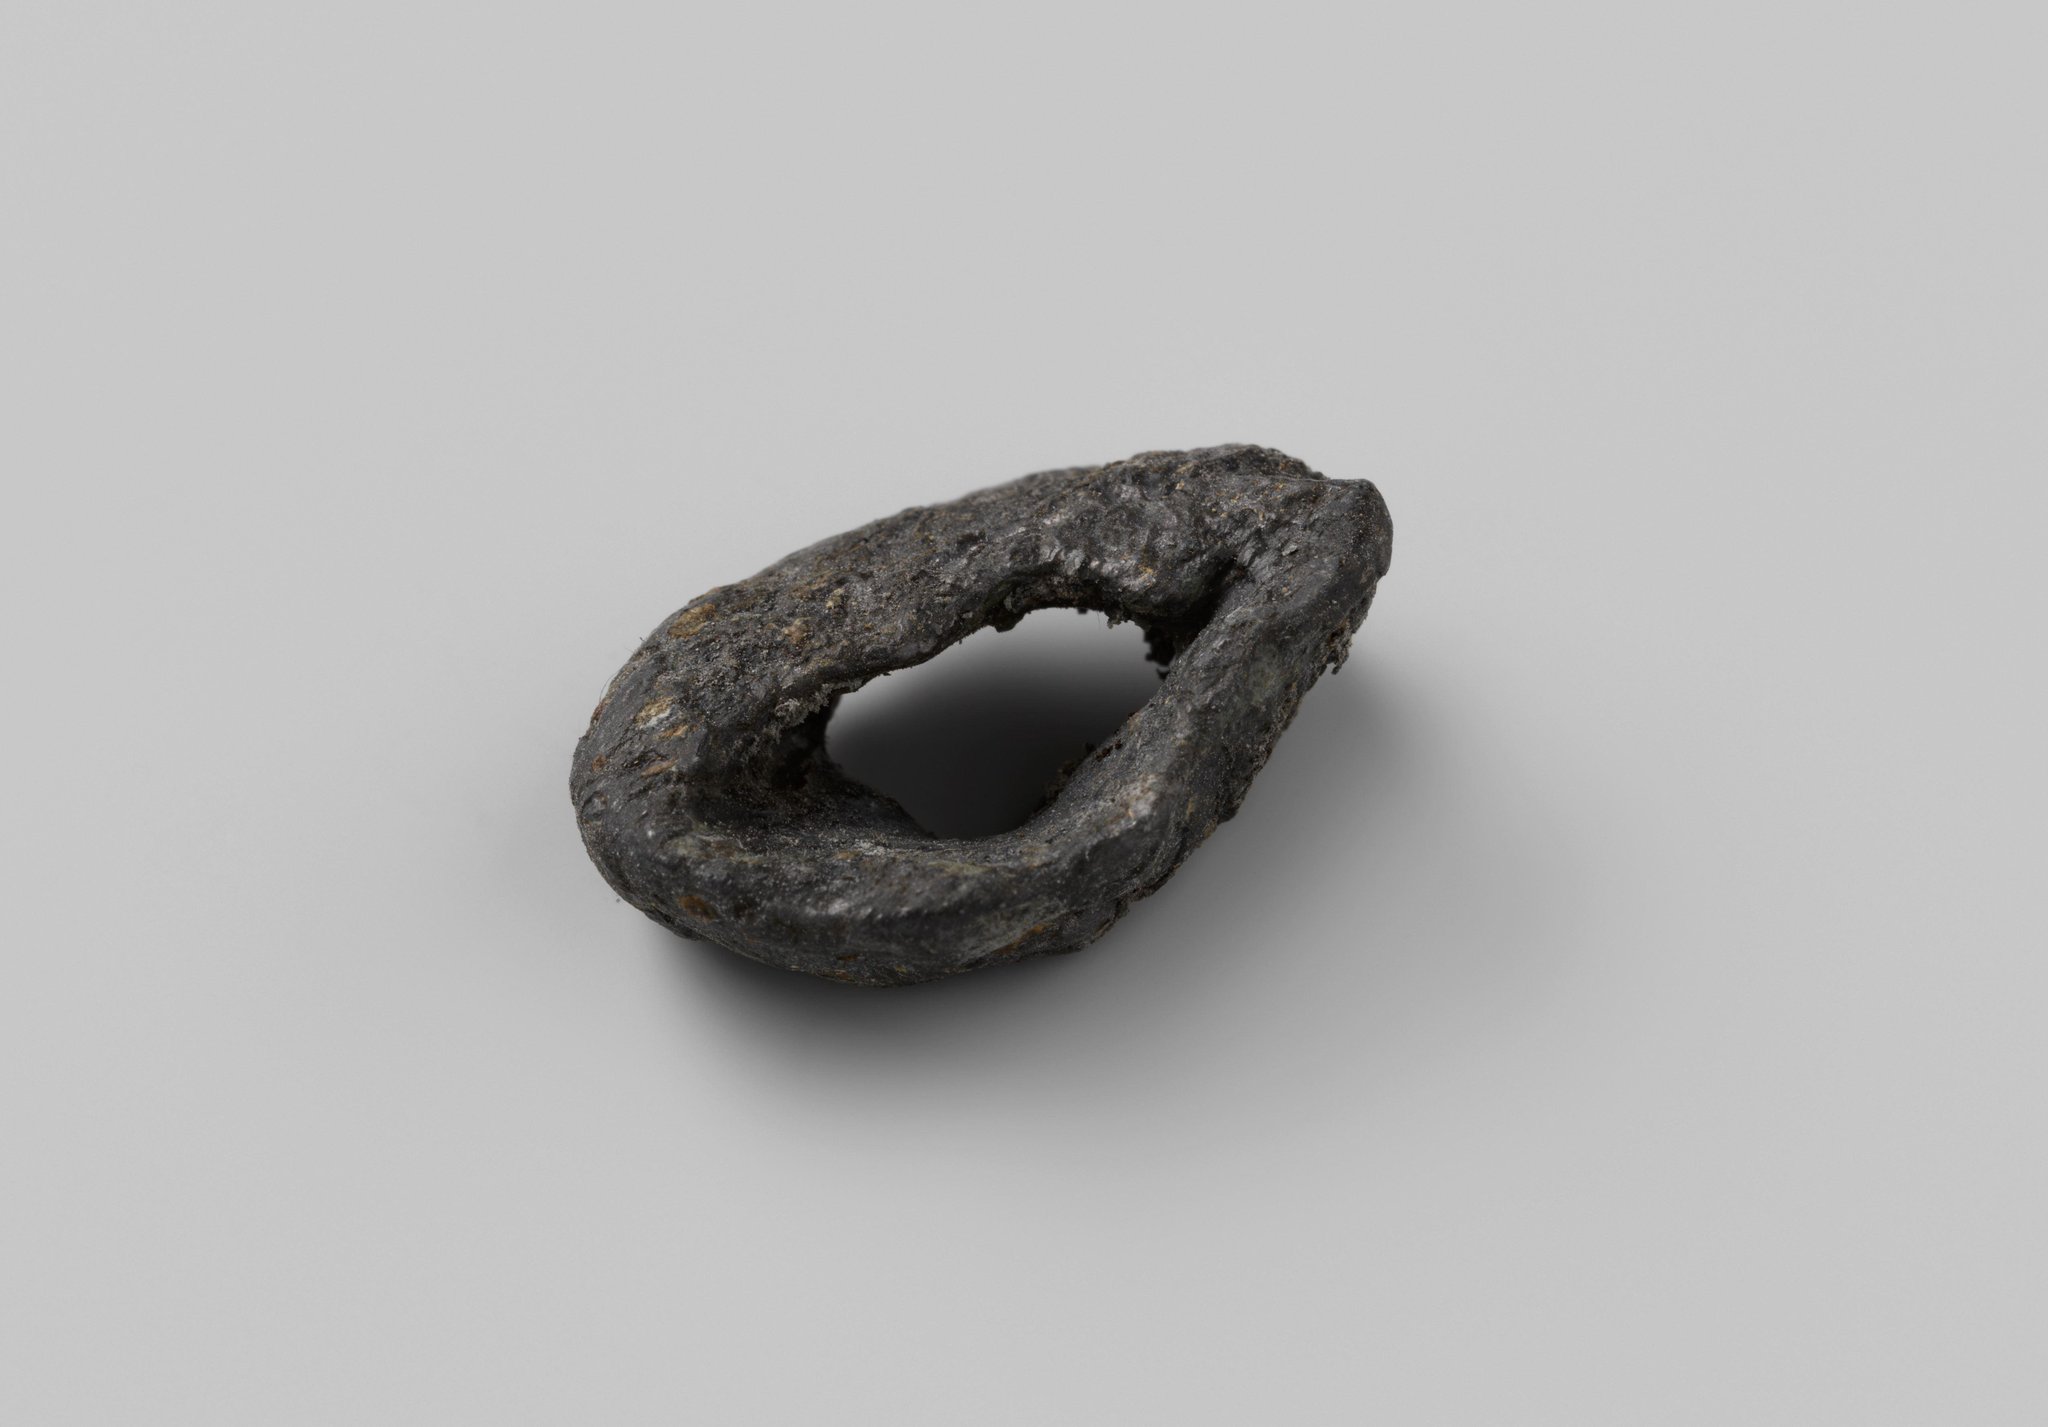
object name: ring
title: Ringvormig fragment uit het wrak van de Oost-Indiëvaarder Hollandia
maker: Anonymous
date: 1700-1743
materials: lead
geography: netherlands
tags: verenigde oostindische compagnie, hollandia (schip), annet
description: Varied parts or fragments, rings and ring-shaped fragments; squashed, id. 80H787.